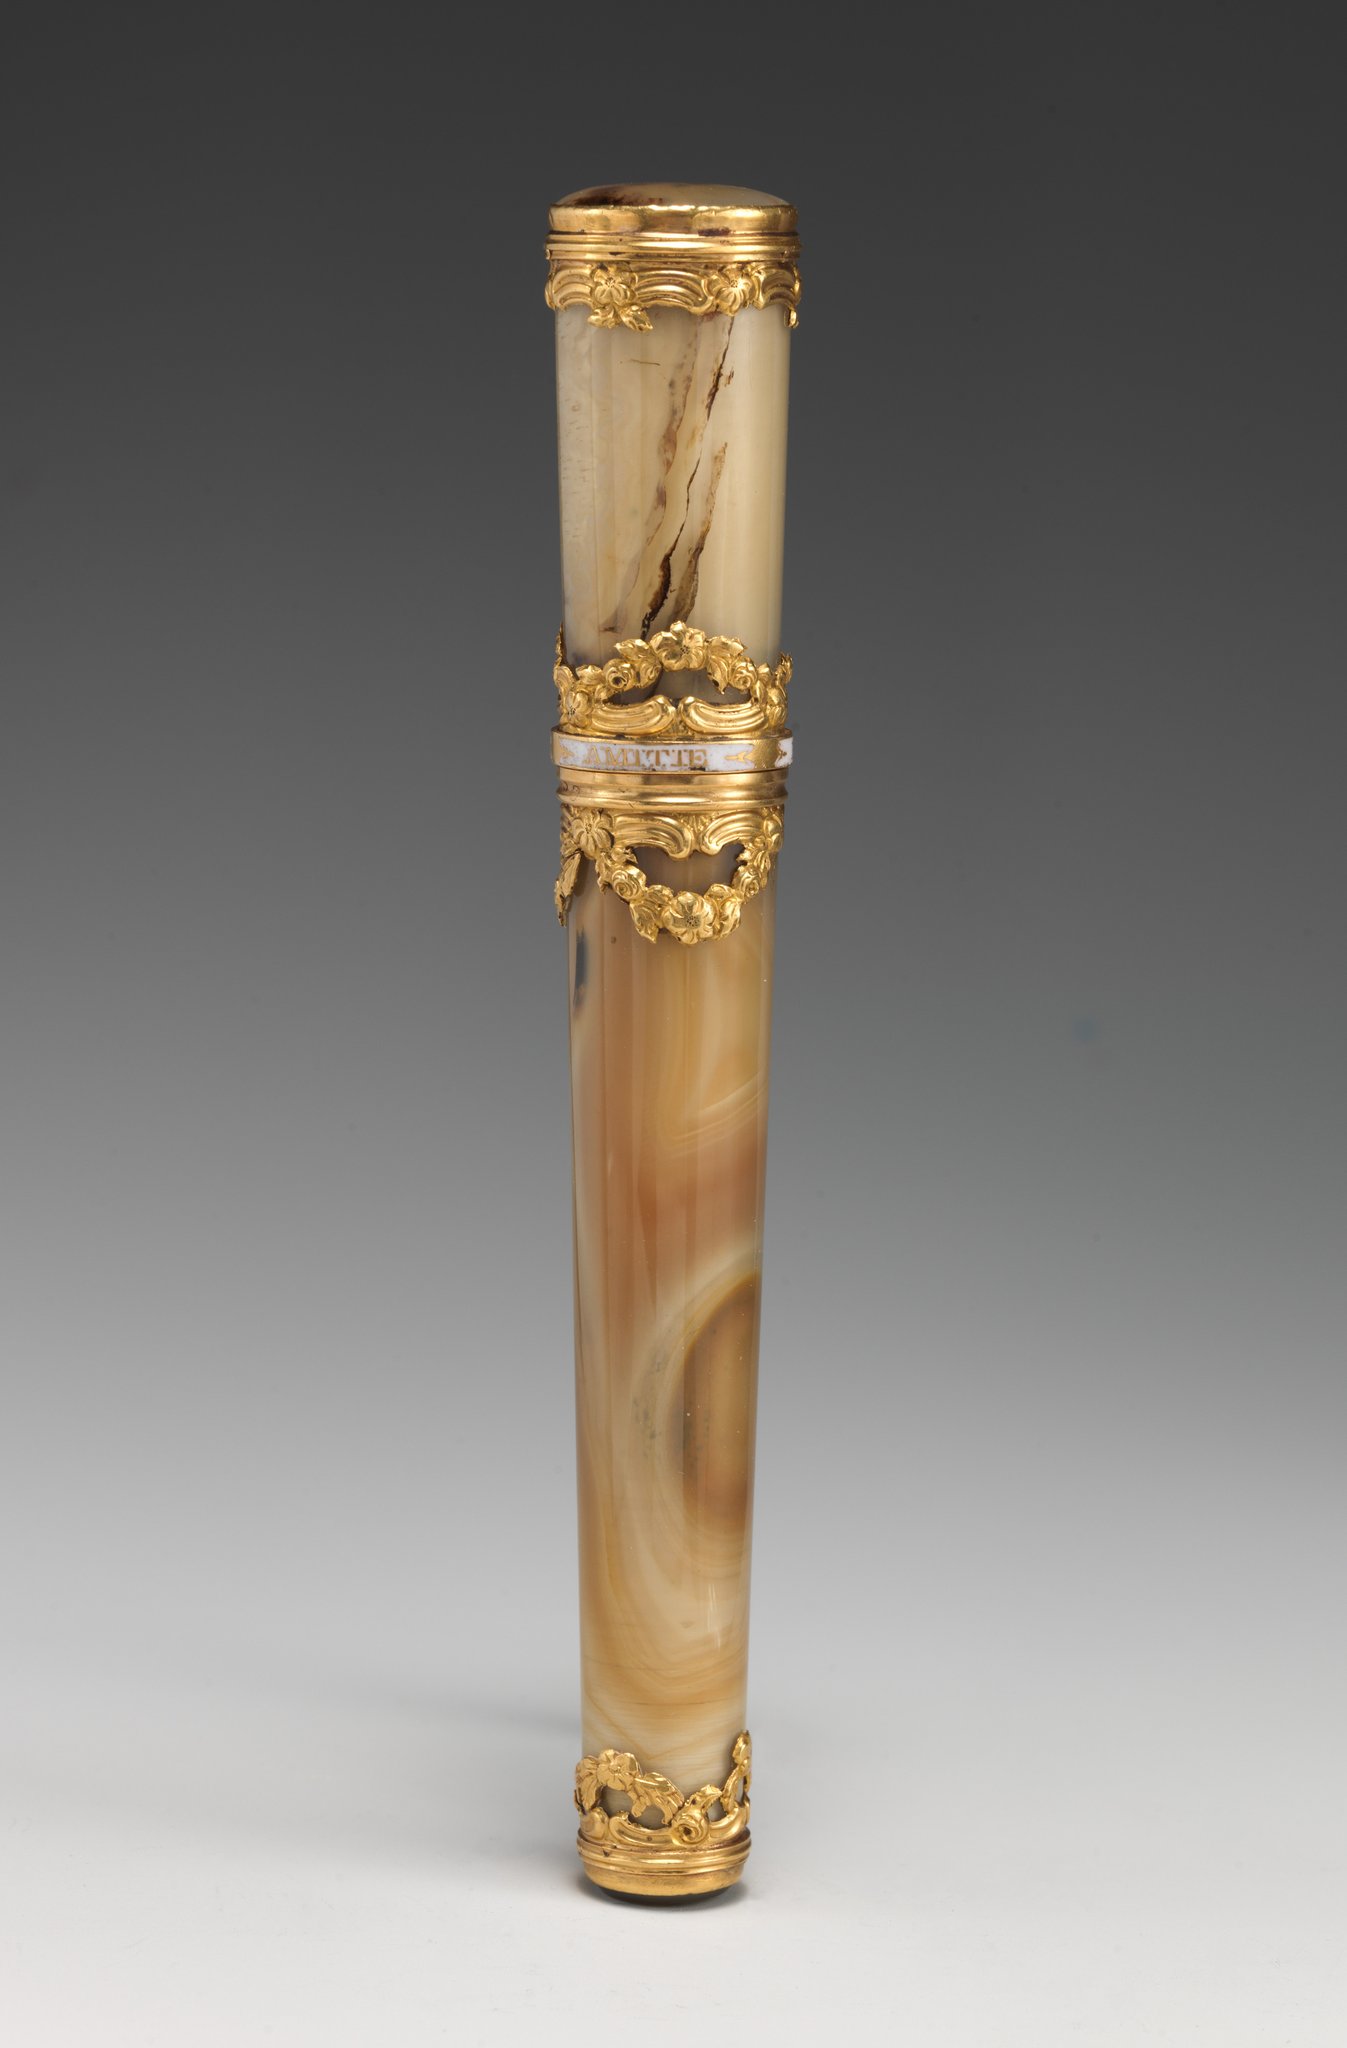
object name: étui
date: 1765-1775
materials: stone, enamel, gold